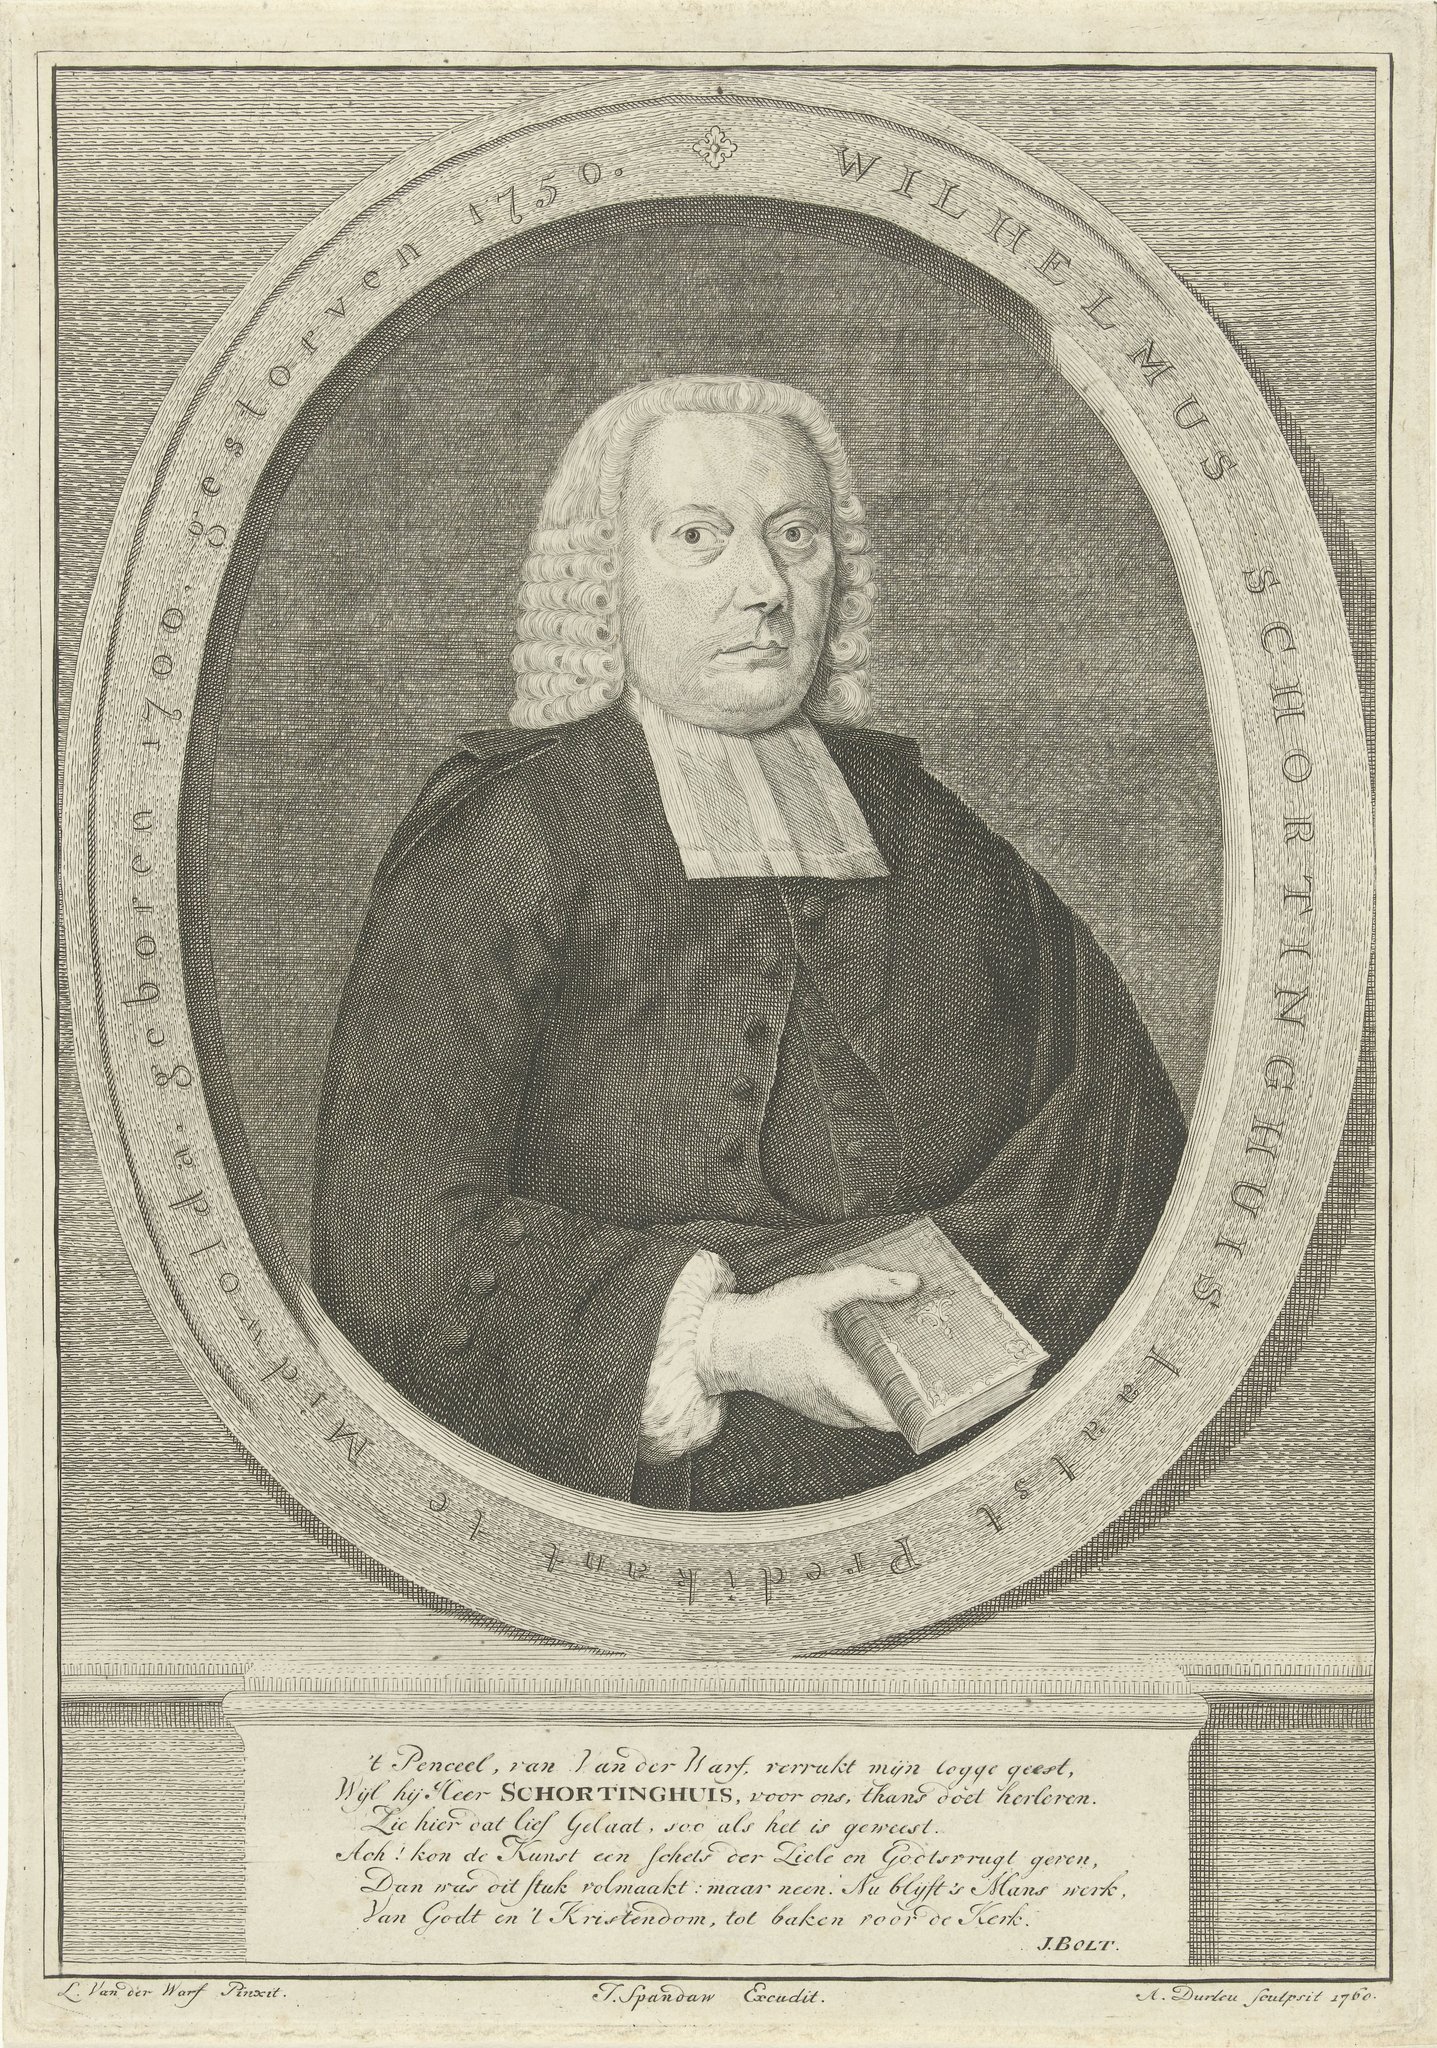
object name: print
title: Portret van de predikant Wilhelmus Schortinghuis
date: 1760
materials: paper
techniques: engraving, etching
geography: groningen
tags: functionaries and dignitaries ~ protestant churches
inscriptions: collector's mark: Lugt 2228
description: Portret van de gereformeerde predikant Wilhelmus Schortinghuis, in ovaal met randschrift. Onder het portret een Nederlands vers op Schortinghuis' leven, geschreven door J. Bolt.